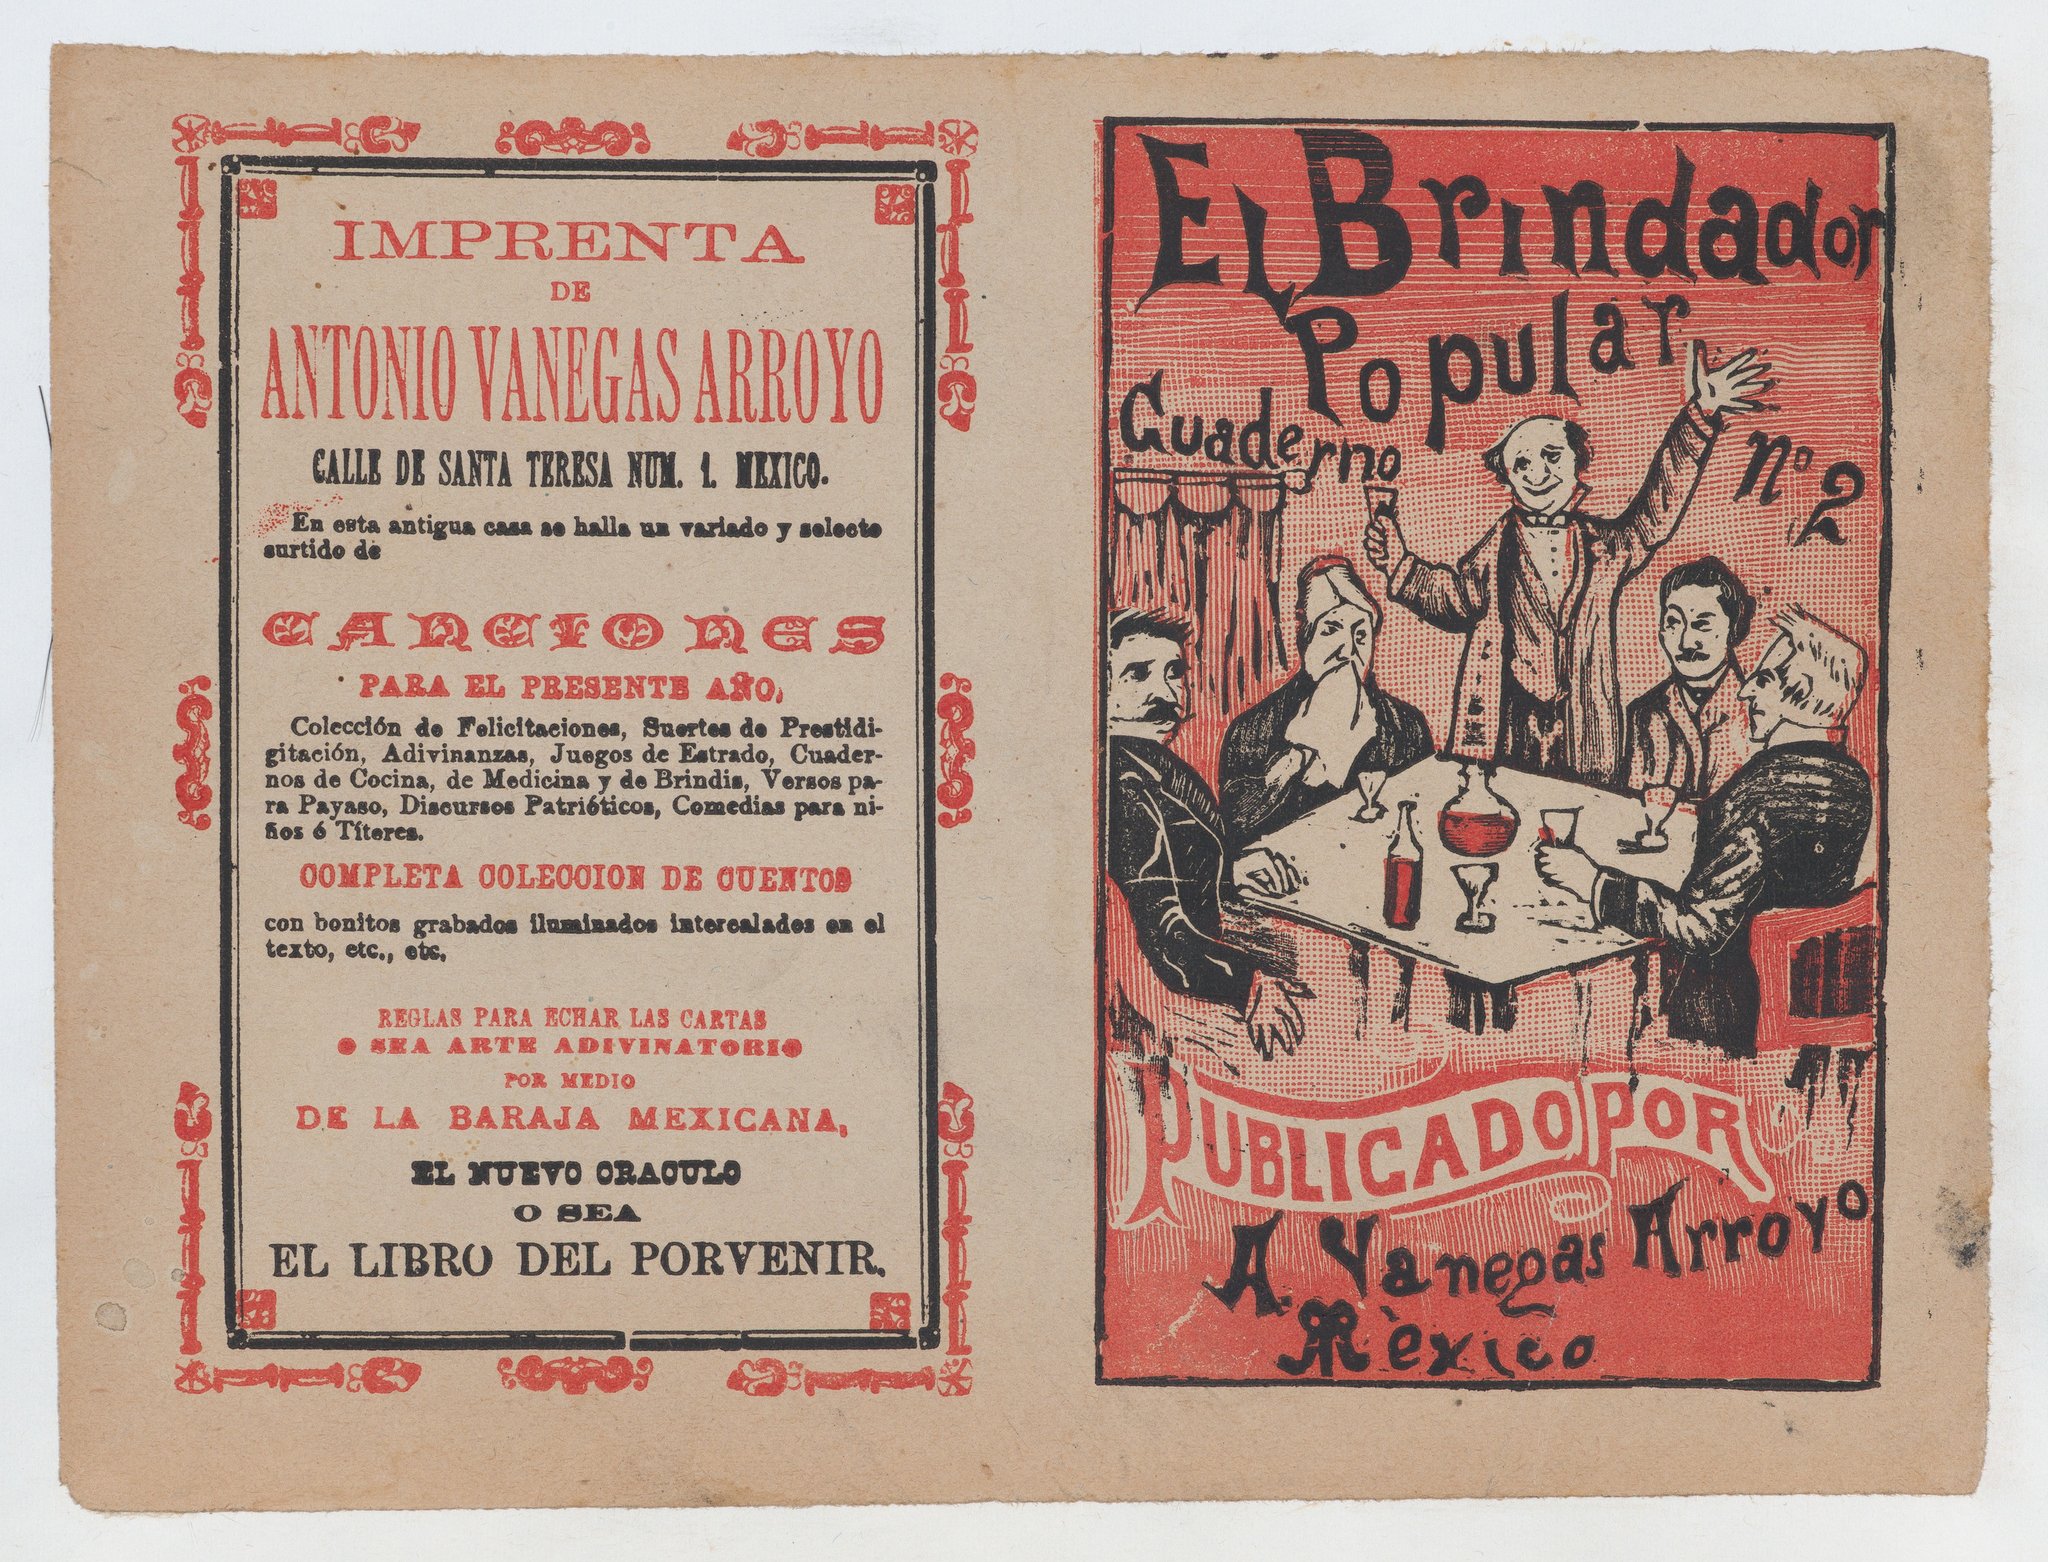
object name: print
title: Cover for 'El Brindador Popular', a man raising a toast to a group of people seated around a table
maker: josé guadalupe posada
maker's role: artist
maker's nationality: mexican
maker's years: 1852-1913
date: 1880-1910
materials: ink, metal, paper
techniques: engraving, letterpress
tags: men,drinking,tables